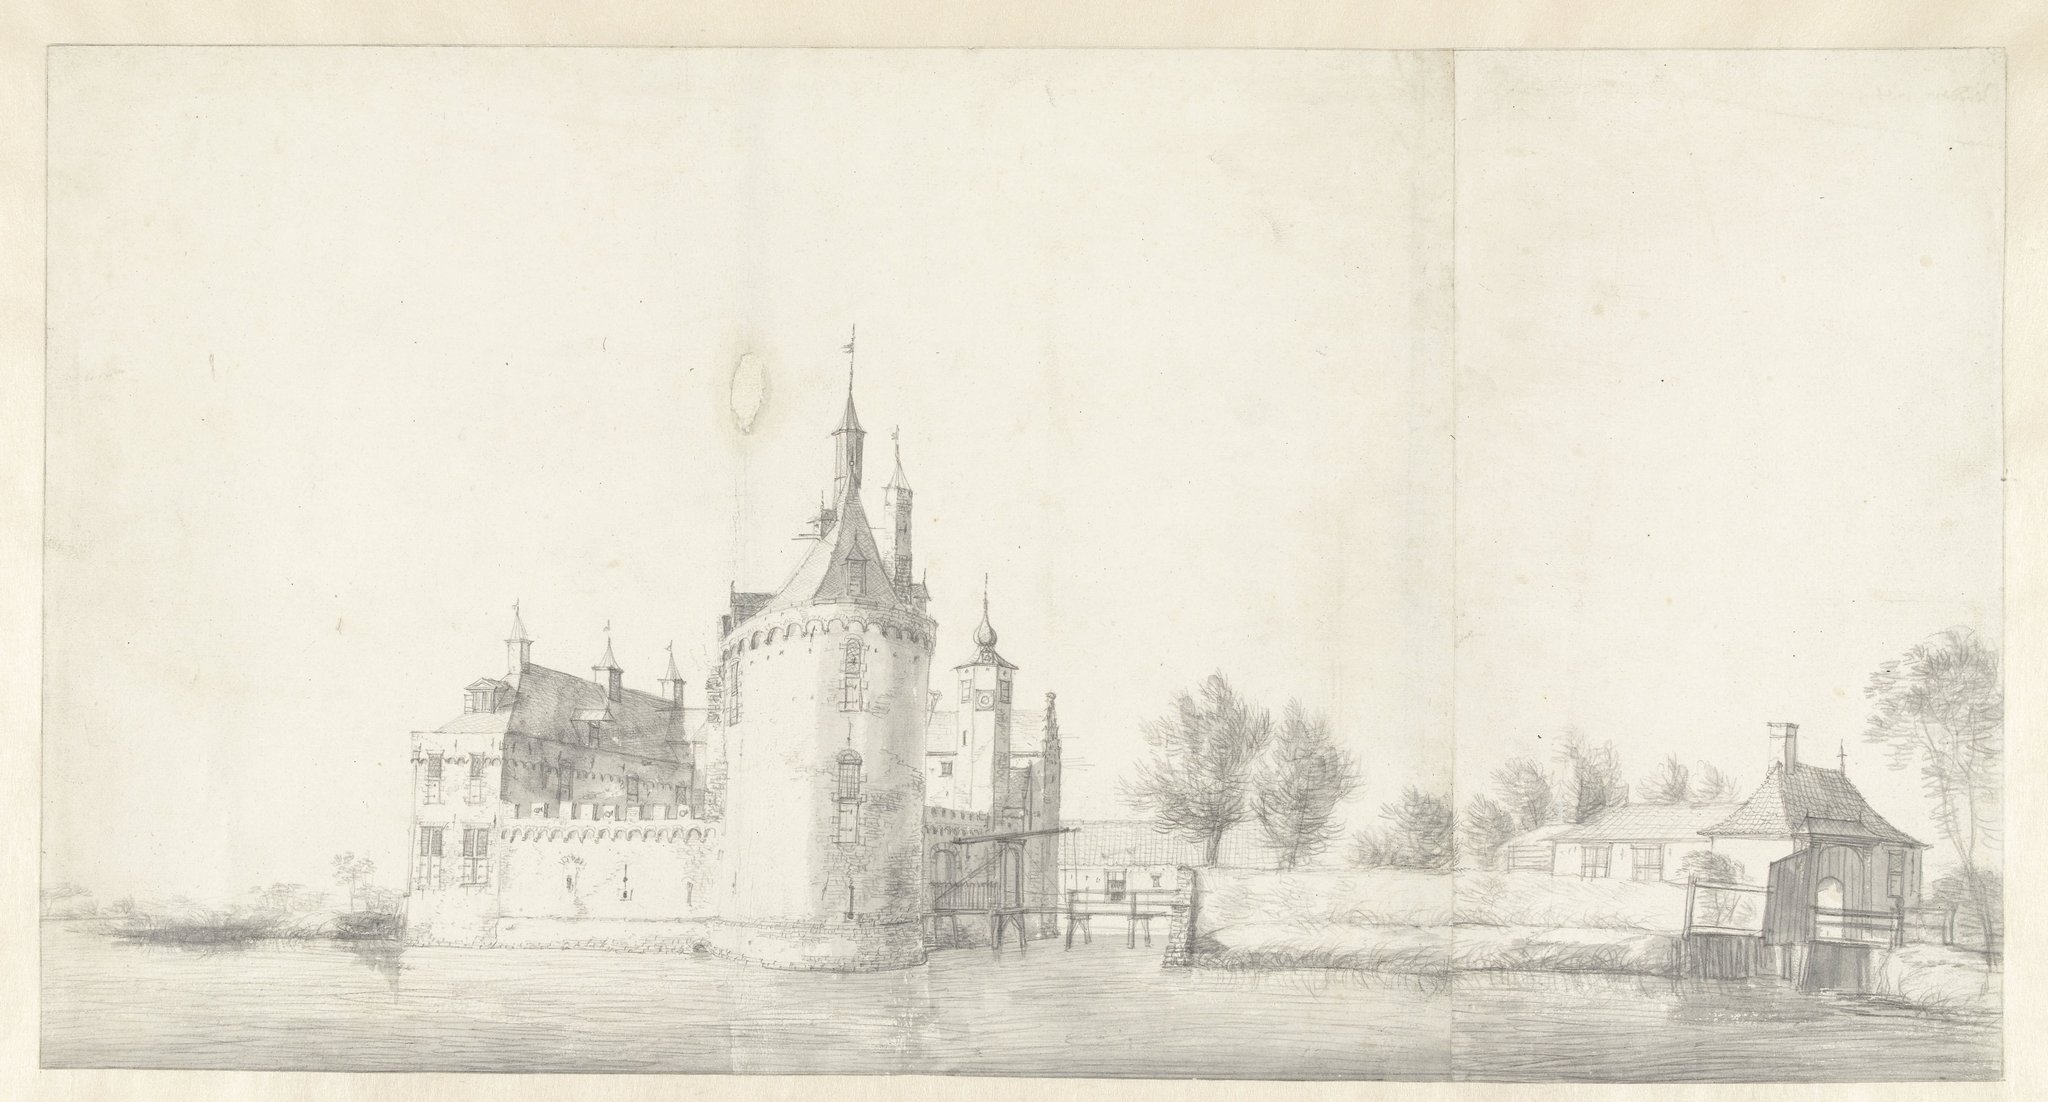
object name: drawing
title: Het Kasteel Tongelaar bij Gassel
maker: jan abrahamsz. beerstraten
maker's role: draughtsman, painter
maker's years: 1622-1666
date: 1632-1666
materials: paper, pencil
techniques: brush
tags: castle